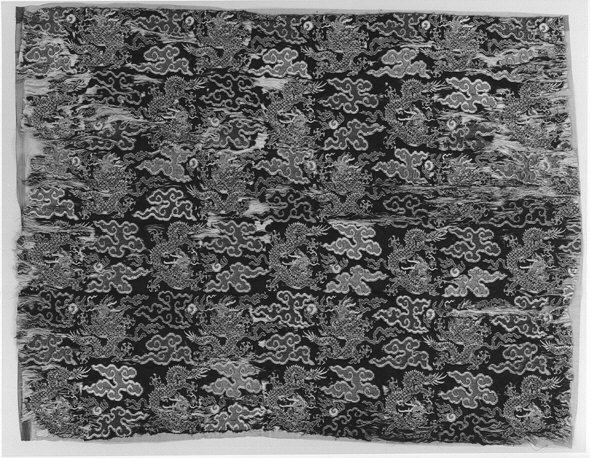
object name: panel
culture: chinese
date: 1662-1722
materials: metal thread, silk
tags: dragons